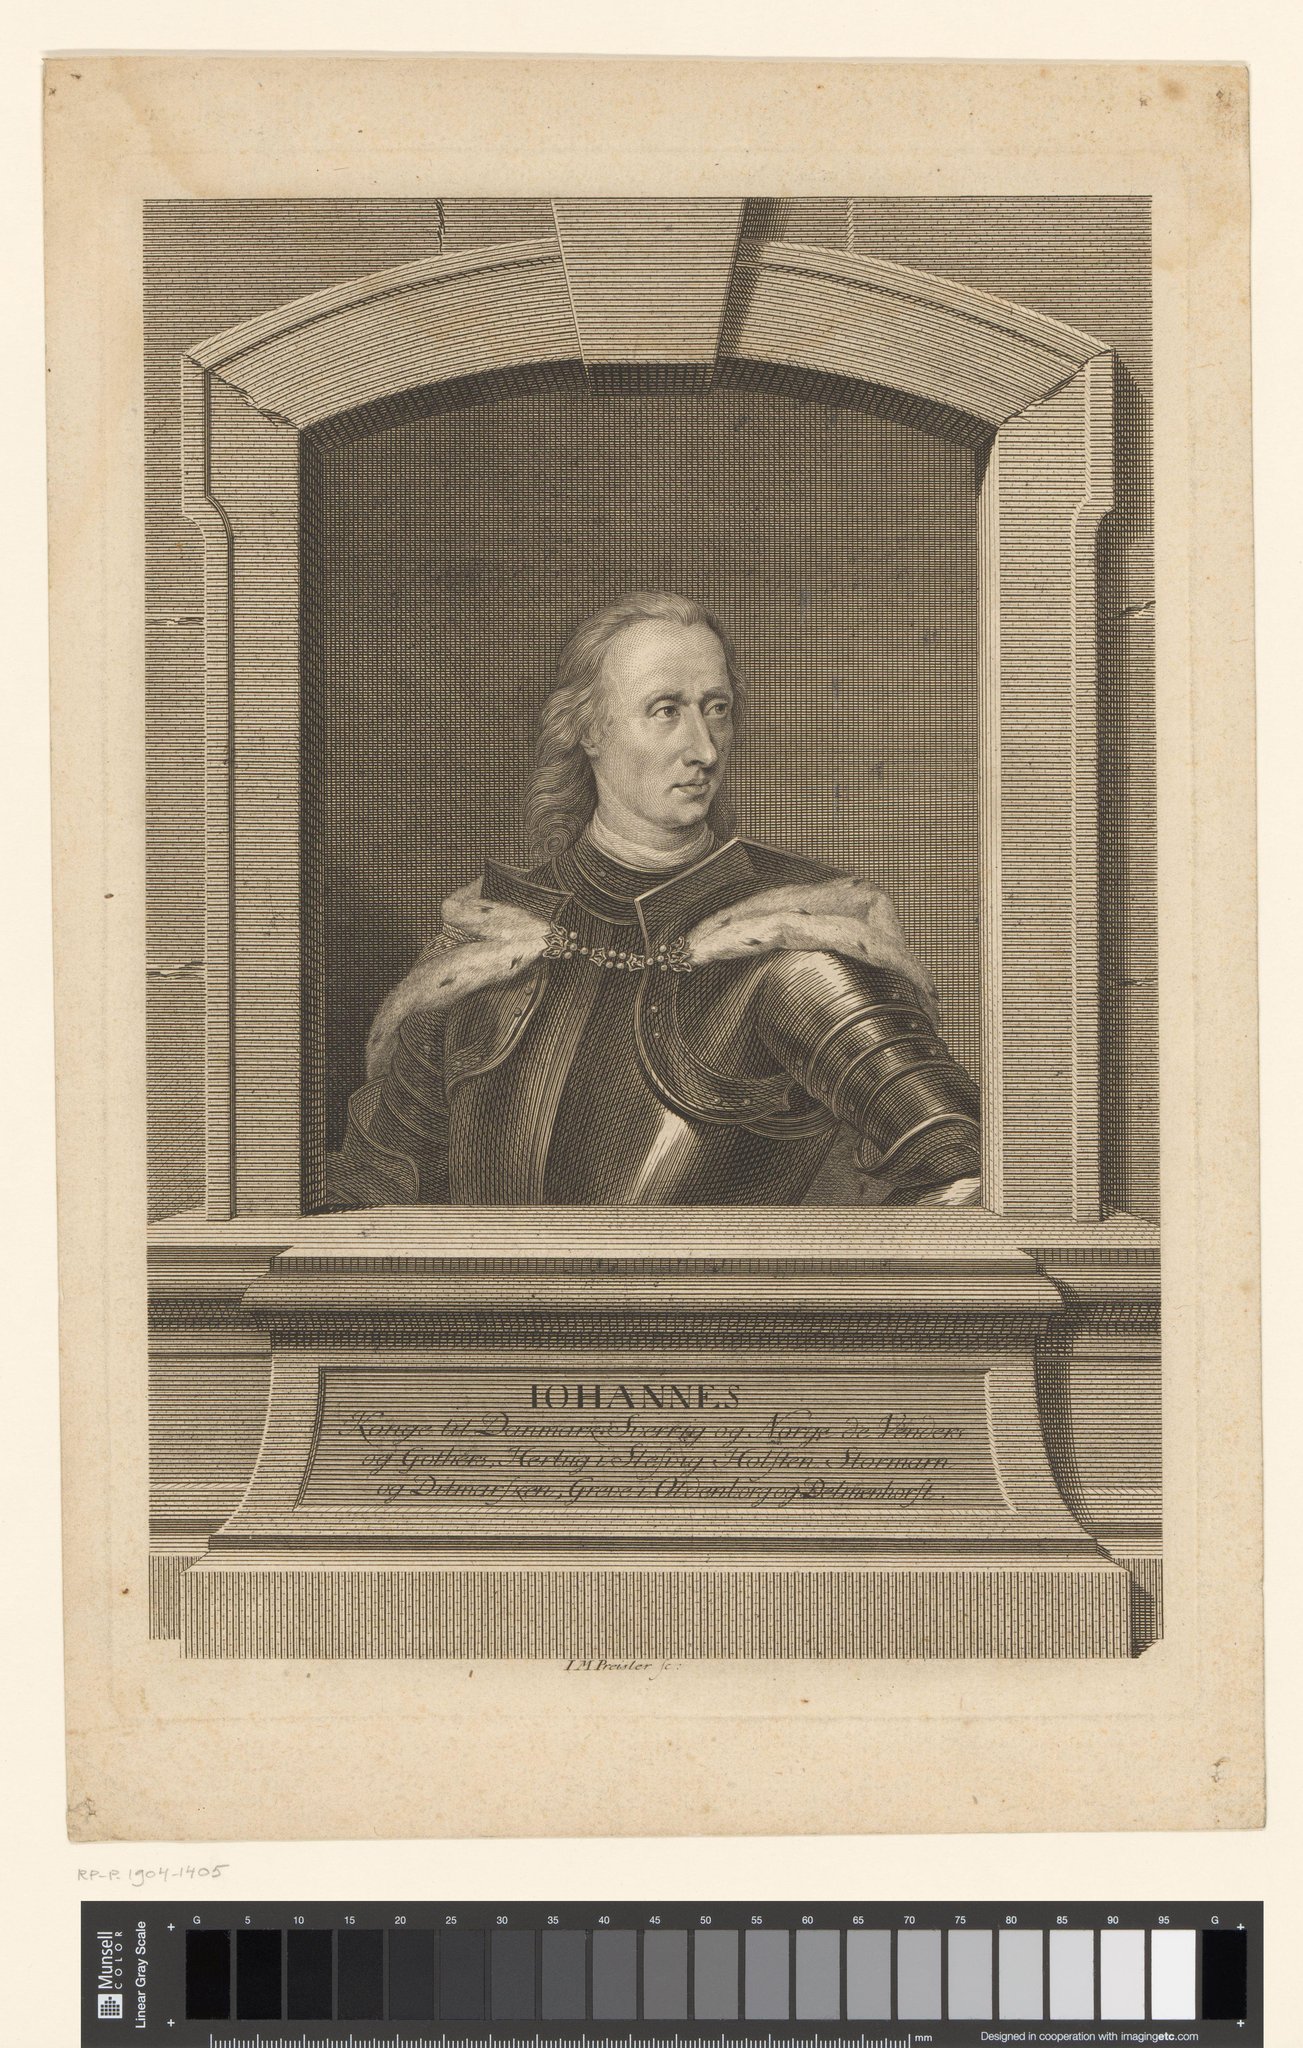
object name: print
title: Johan, koning van Denemarken, Noorwegen en Zweden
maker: johann martin preissler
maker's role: print maker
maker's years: 1715-1794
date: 1769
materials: paper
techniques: engraving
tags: armour, historical persons, insignia and symbols of sovereignty (crown, diadem, sceptre, orb, seal, standard, cloak, pectoral)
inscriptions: collector's mark: Lugt 2228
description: Prent ook gebruikt in: Schlegel, Johann Heinrich. Geschichte der Könige von Dänemark aus dem Oldenburgischen Stamme. Kopenhagen: Nicolaus Moller, 1769.